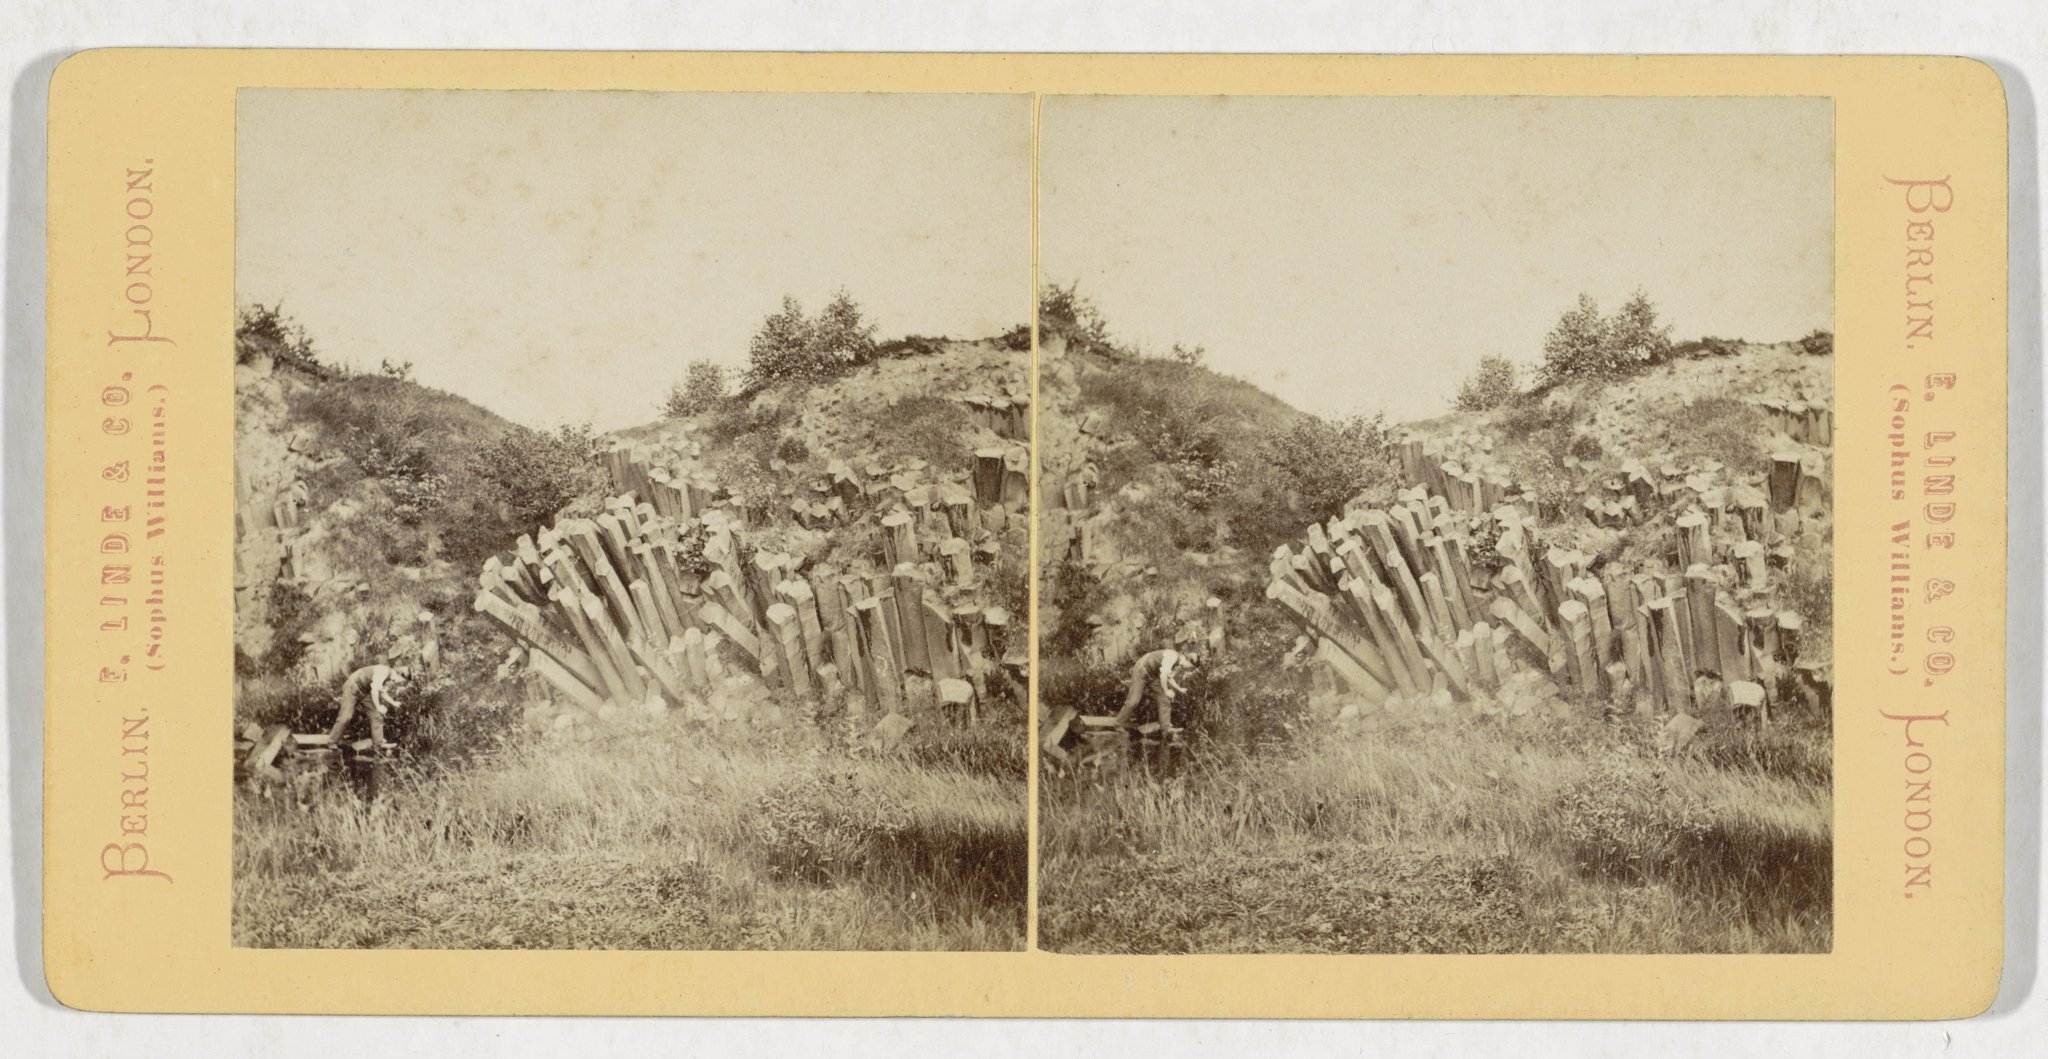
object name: stereograph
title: Basaltbruch zu Dittelsdorf, bei Zittau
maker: Anonymous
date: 1868-1890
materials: cardboard, paper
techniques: albumen print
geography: berlin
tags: minerals and metals, quarry, rock-formations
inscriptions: number: ‘No 39.’